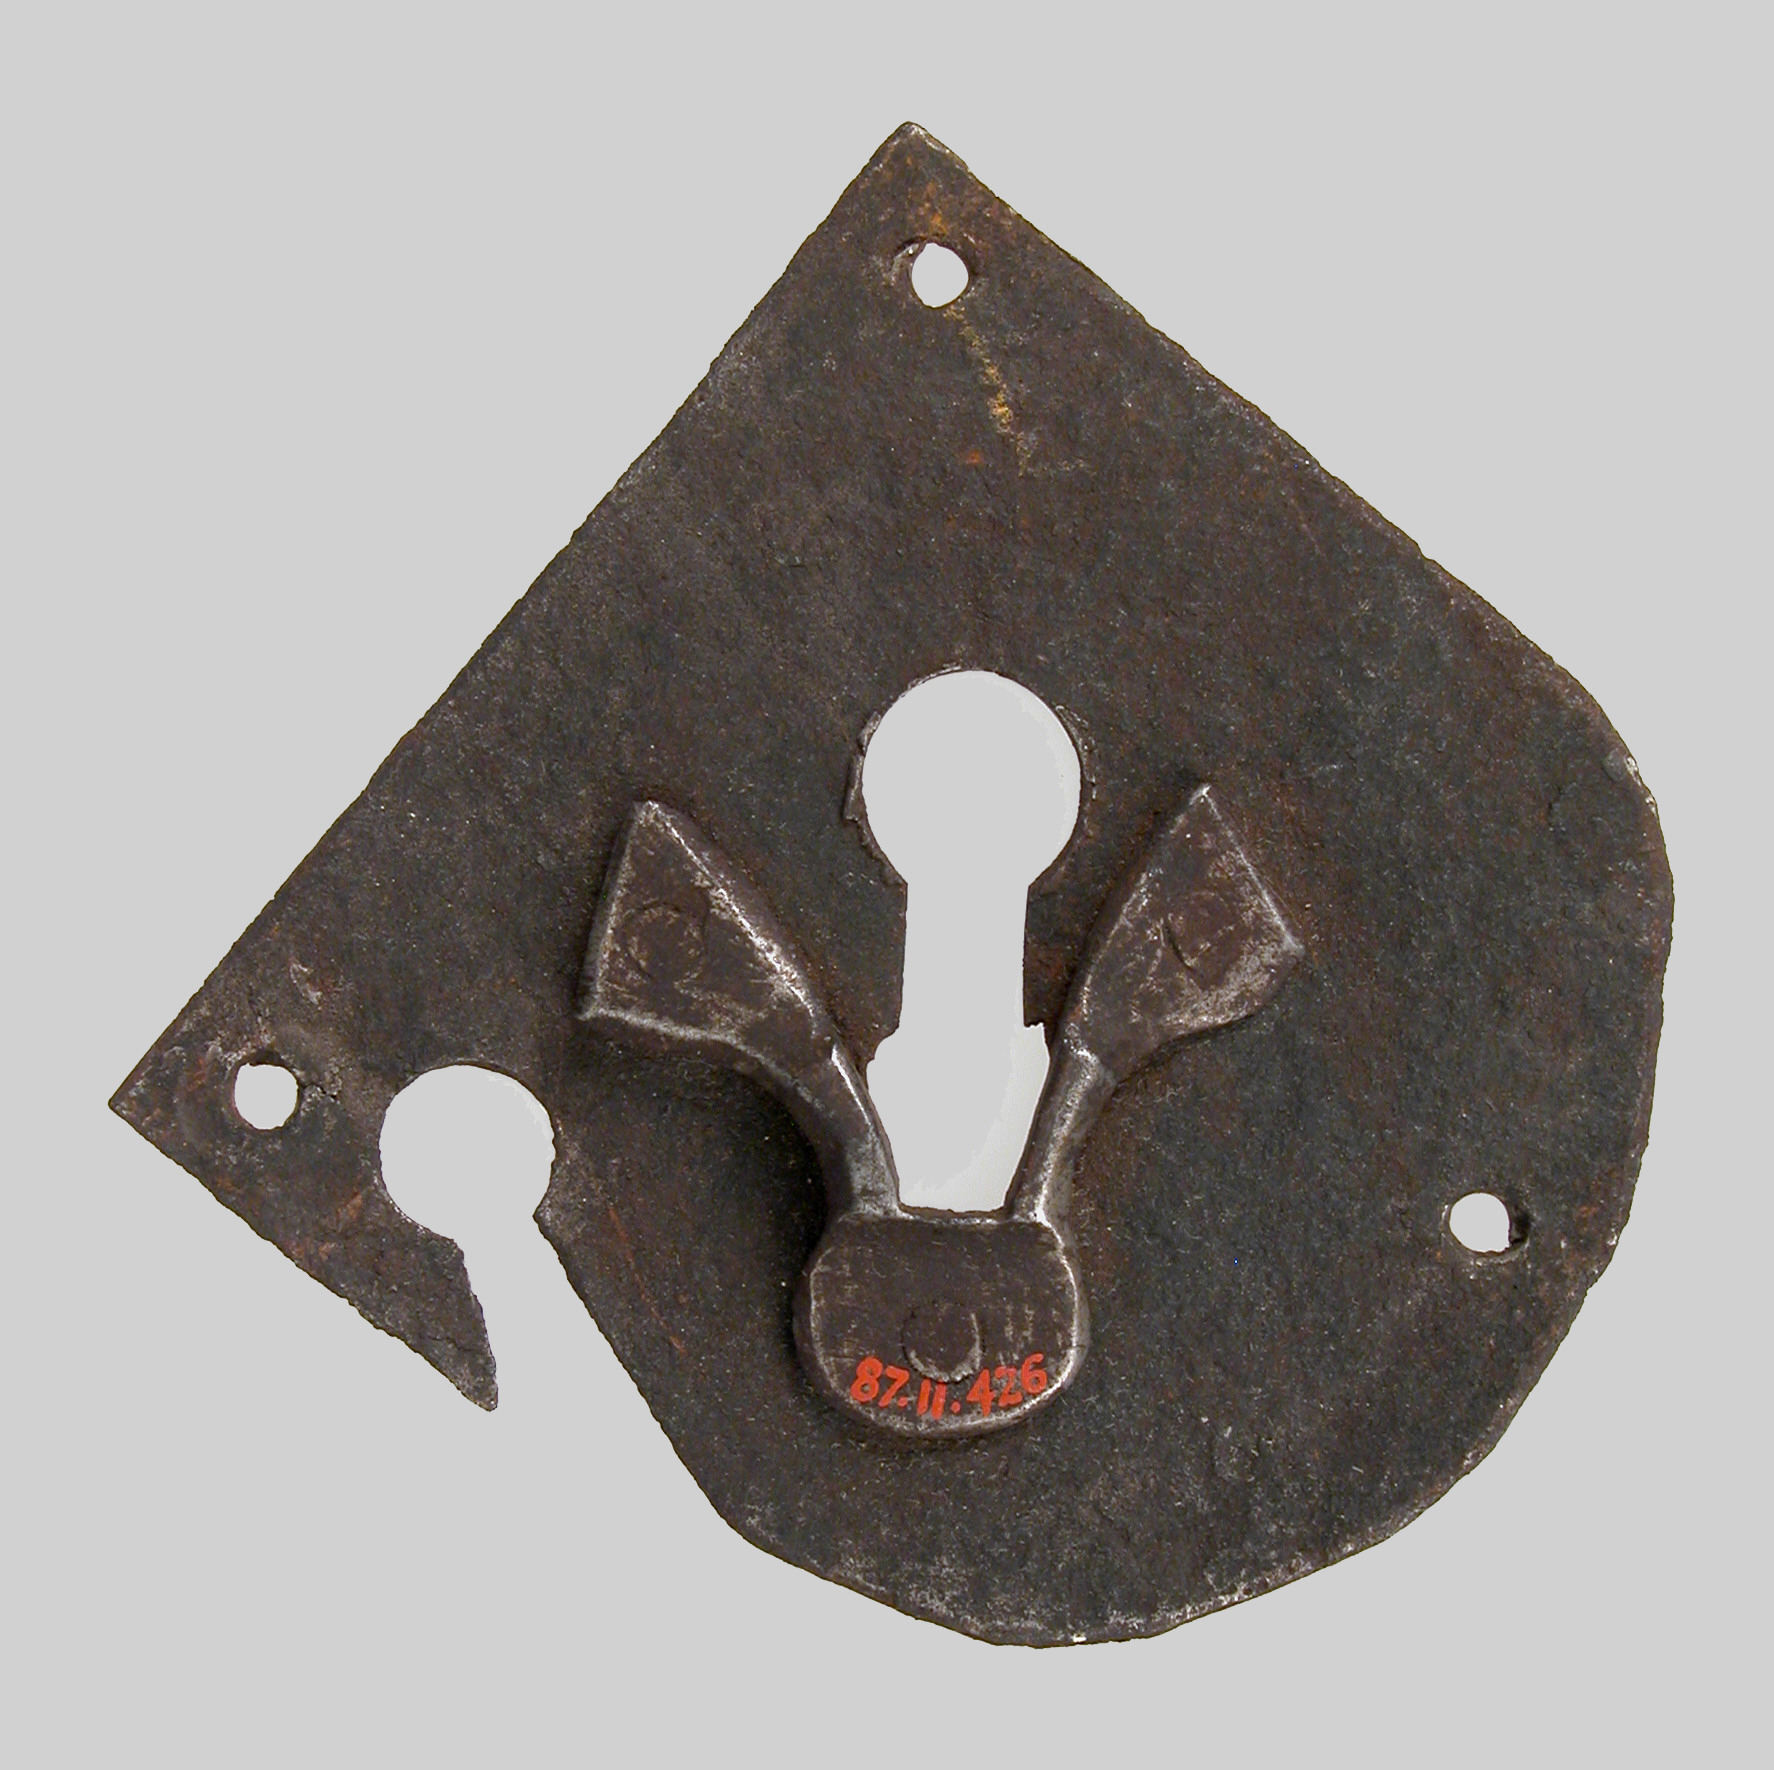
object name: escutcheon plate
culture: german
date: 1401-1500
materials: iron